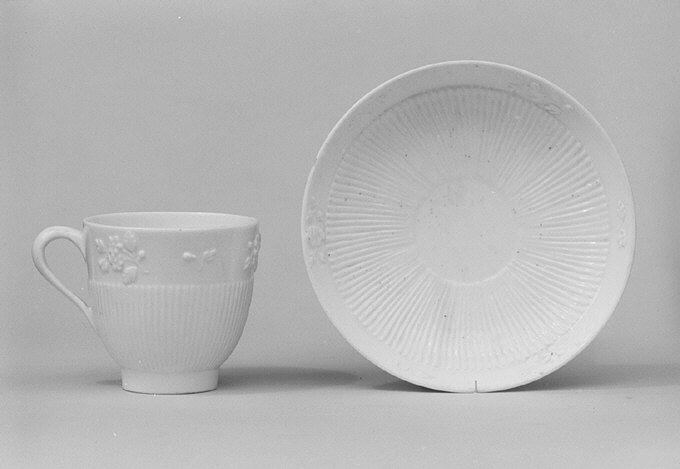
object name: cup and saucer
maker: mennecy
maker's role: factory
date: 1750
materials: soft paste porcelain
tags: flowers